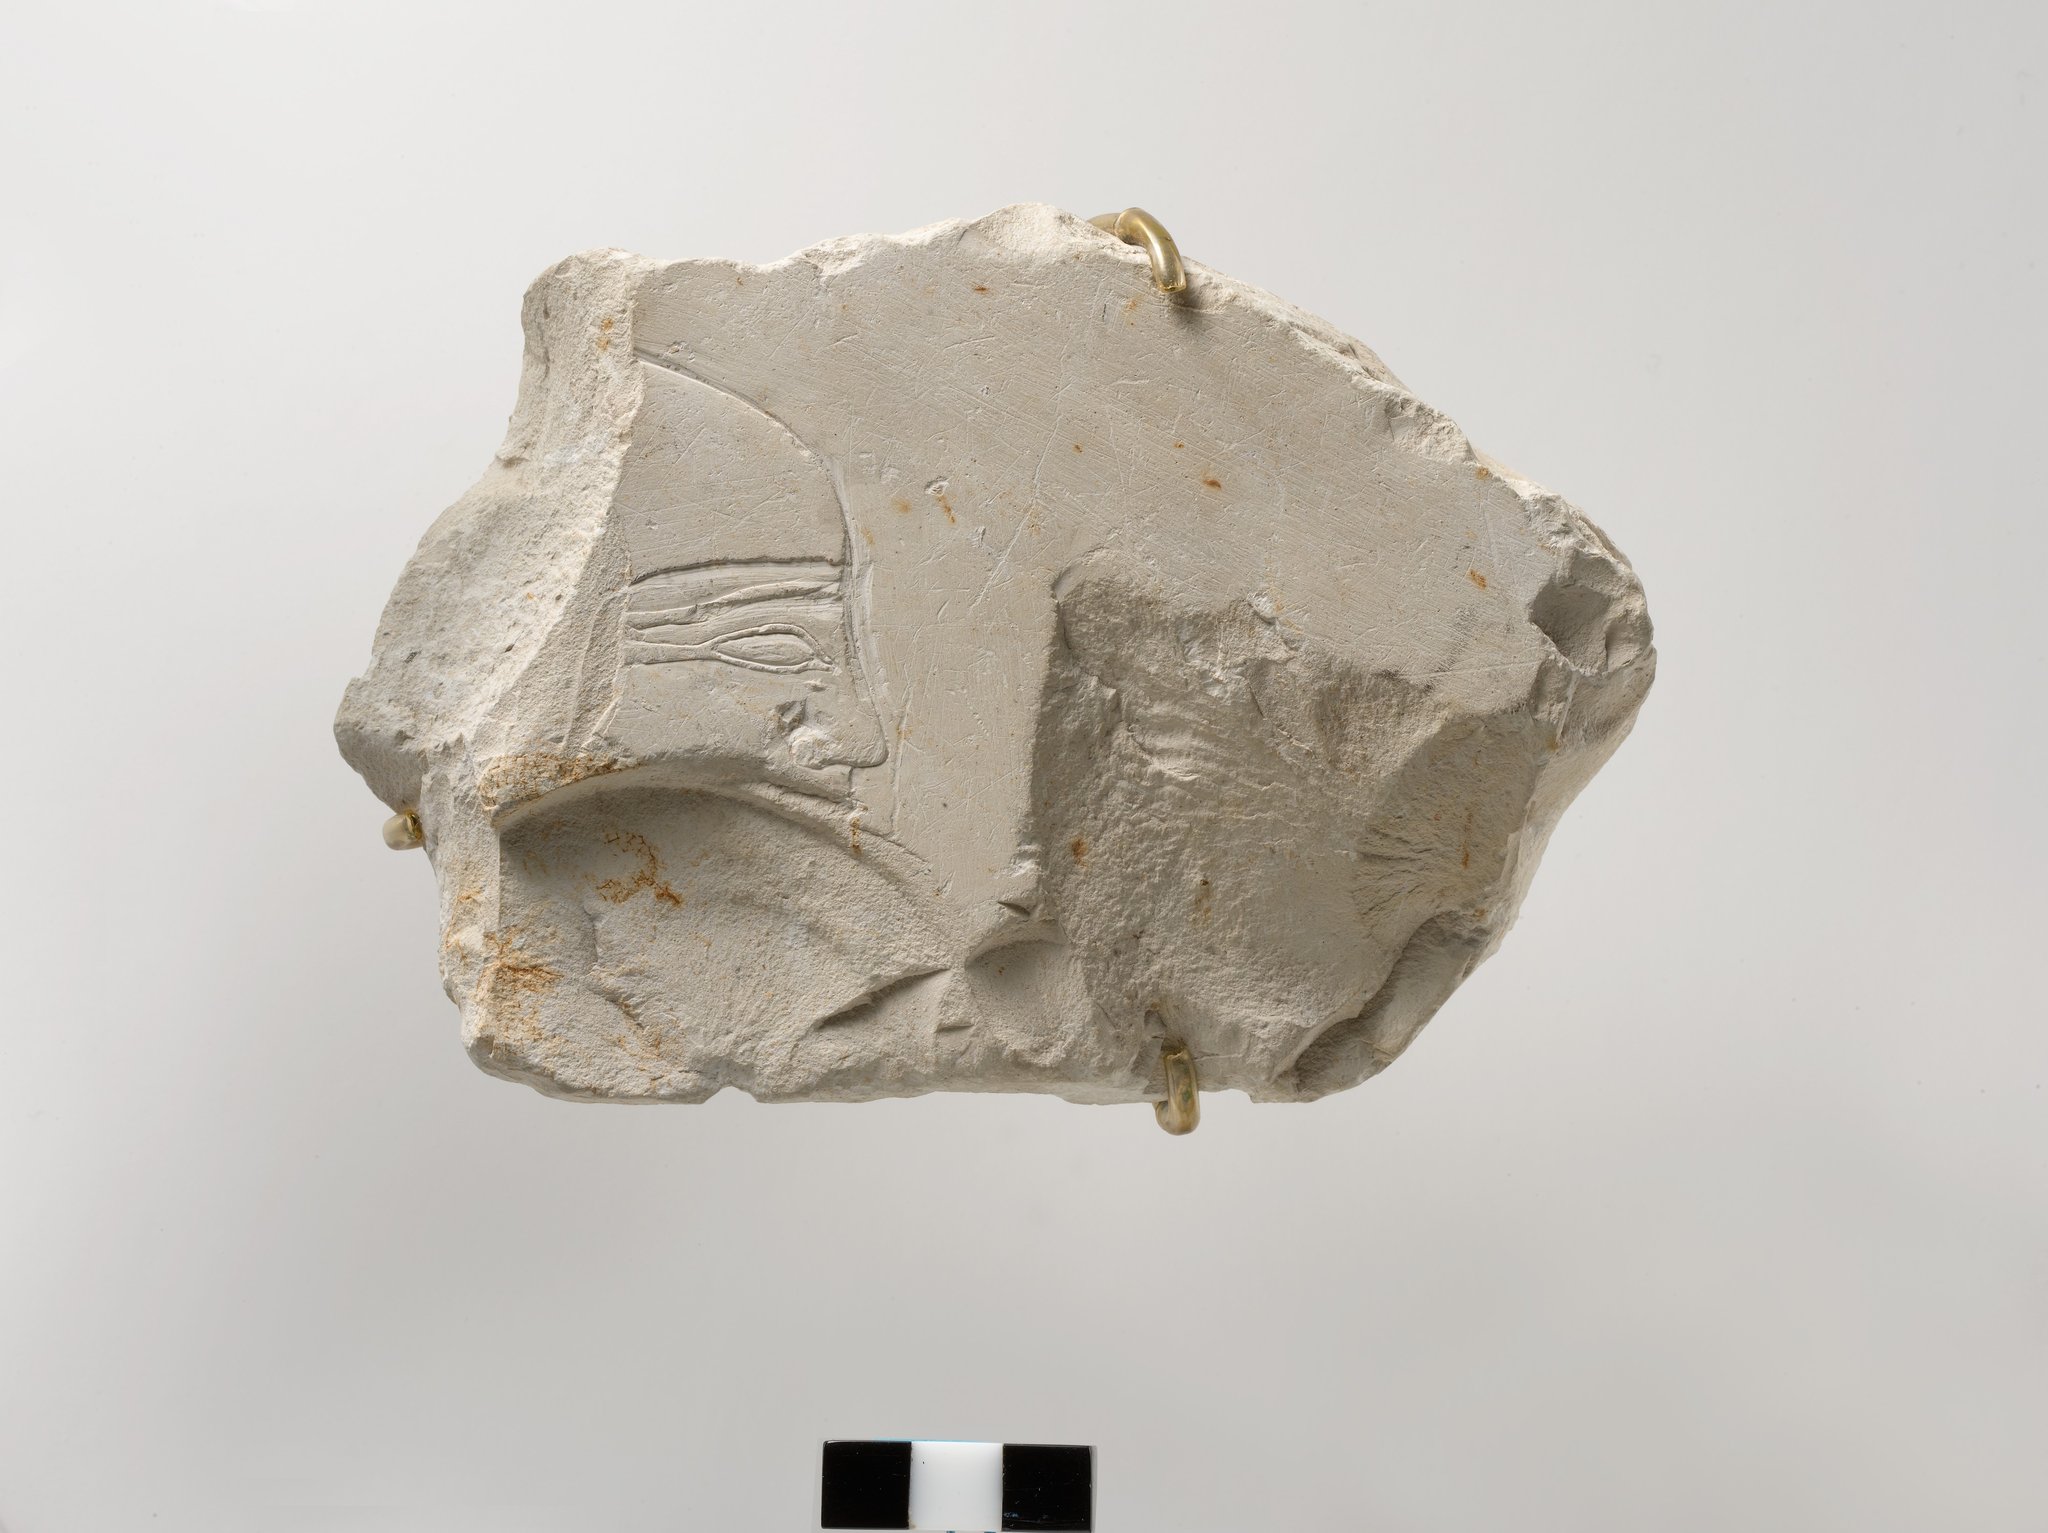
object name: relief fragment, tomb of meketre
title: Relief fragment from tomb of Meketre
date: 1981-1975 BCE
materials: limestone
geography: egypt